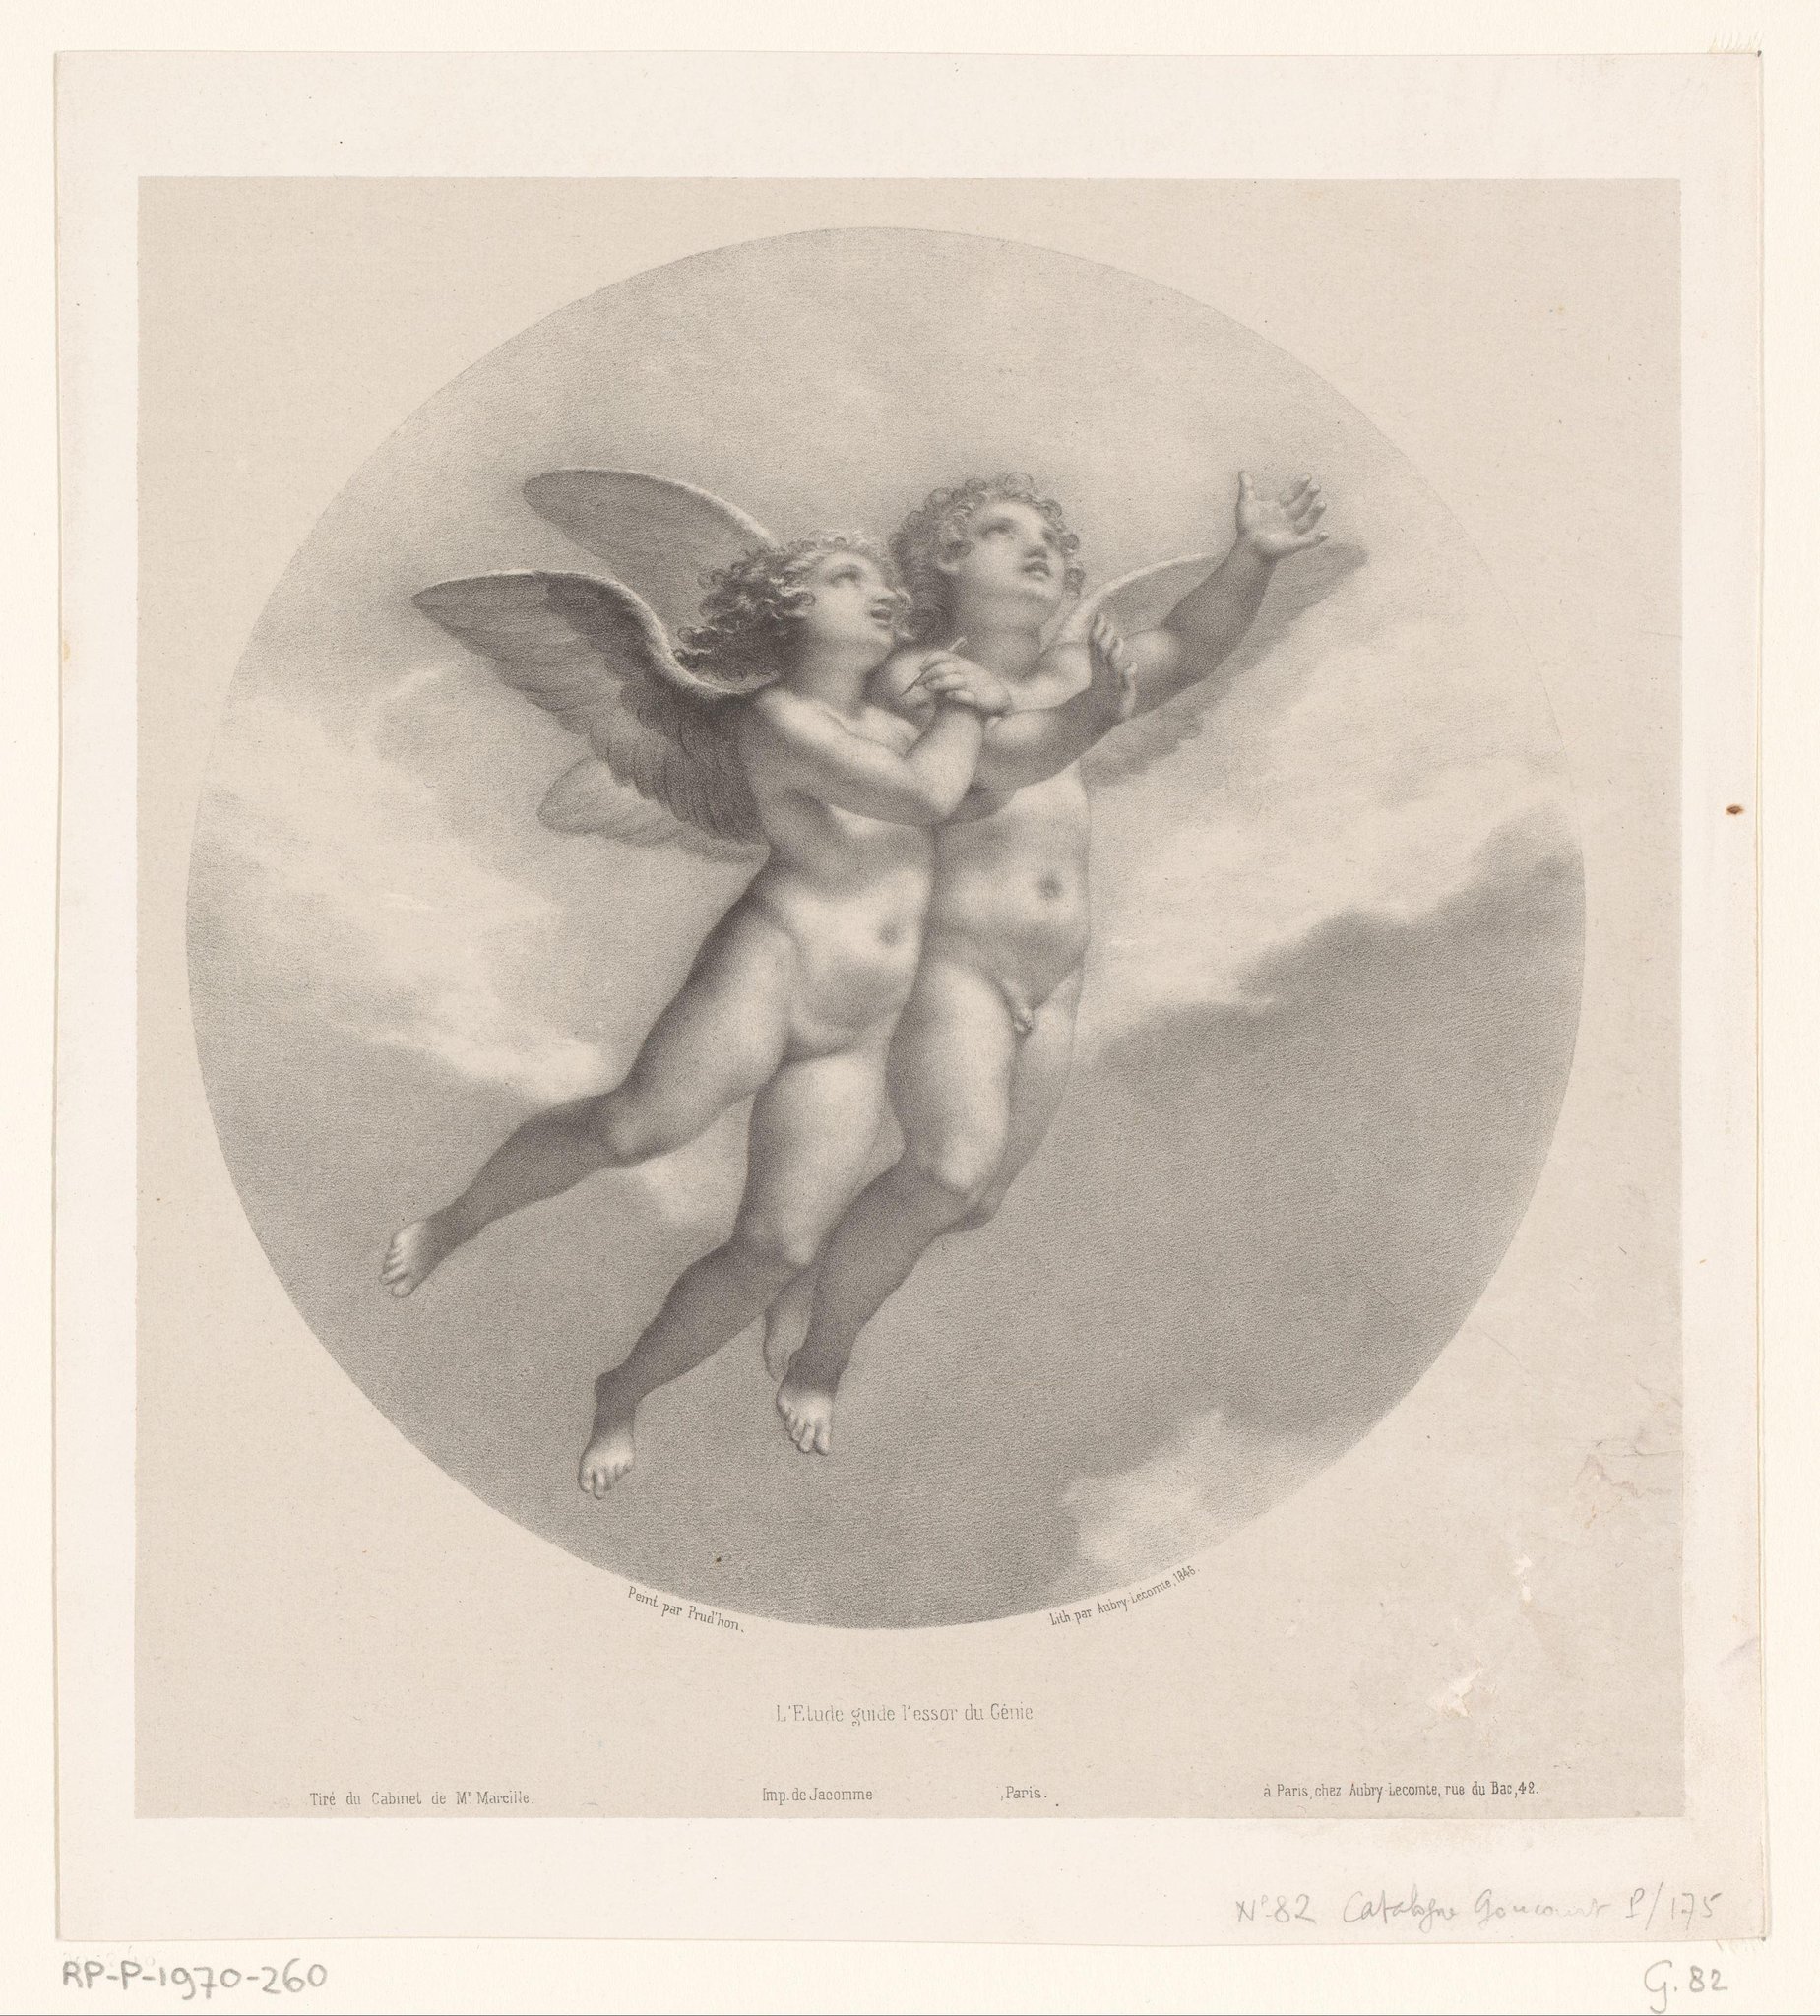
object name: print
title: Studie begeleidt Genius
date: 1846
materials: paper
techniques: lithograph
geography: paris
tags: scholastic education, tuition, 'genio' (ripa)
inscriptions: collector's mark: Lugt 2760, collector's mark: Lugt 2228